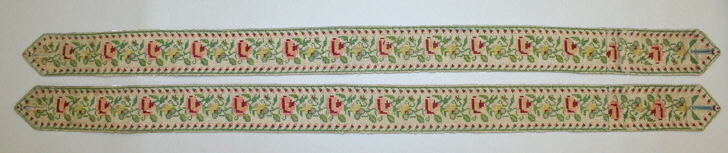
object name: suspender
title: Suspenders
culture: european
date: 1801-1900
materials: cotton, silk